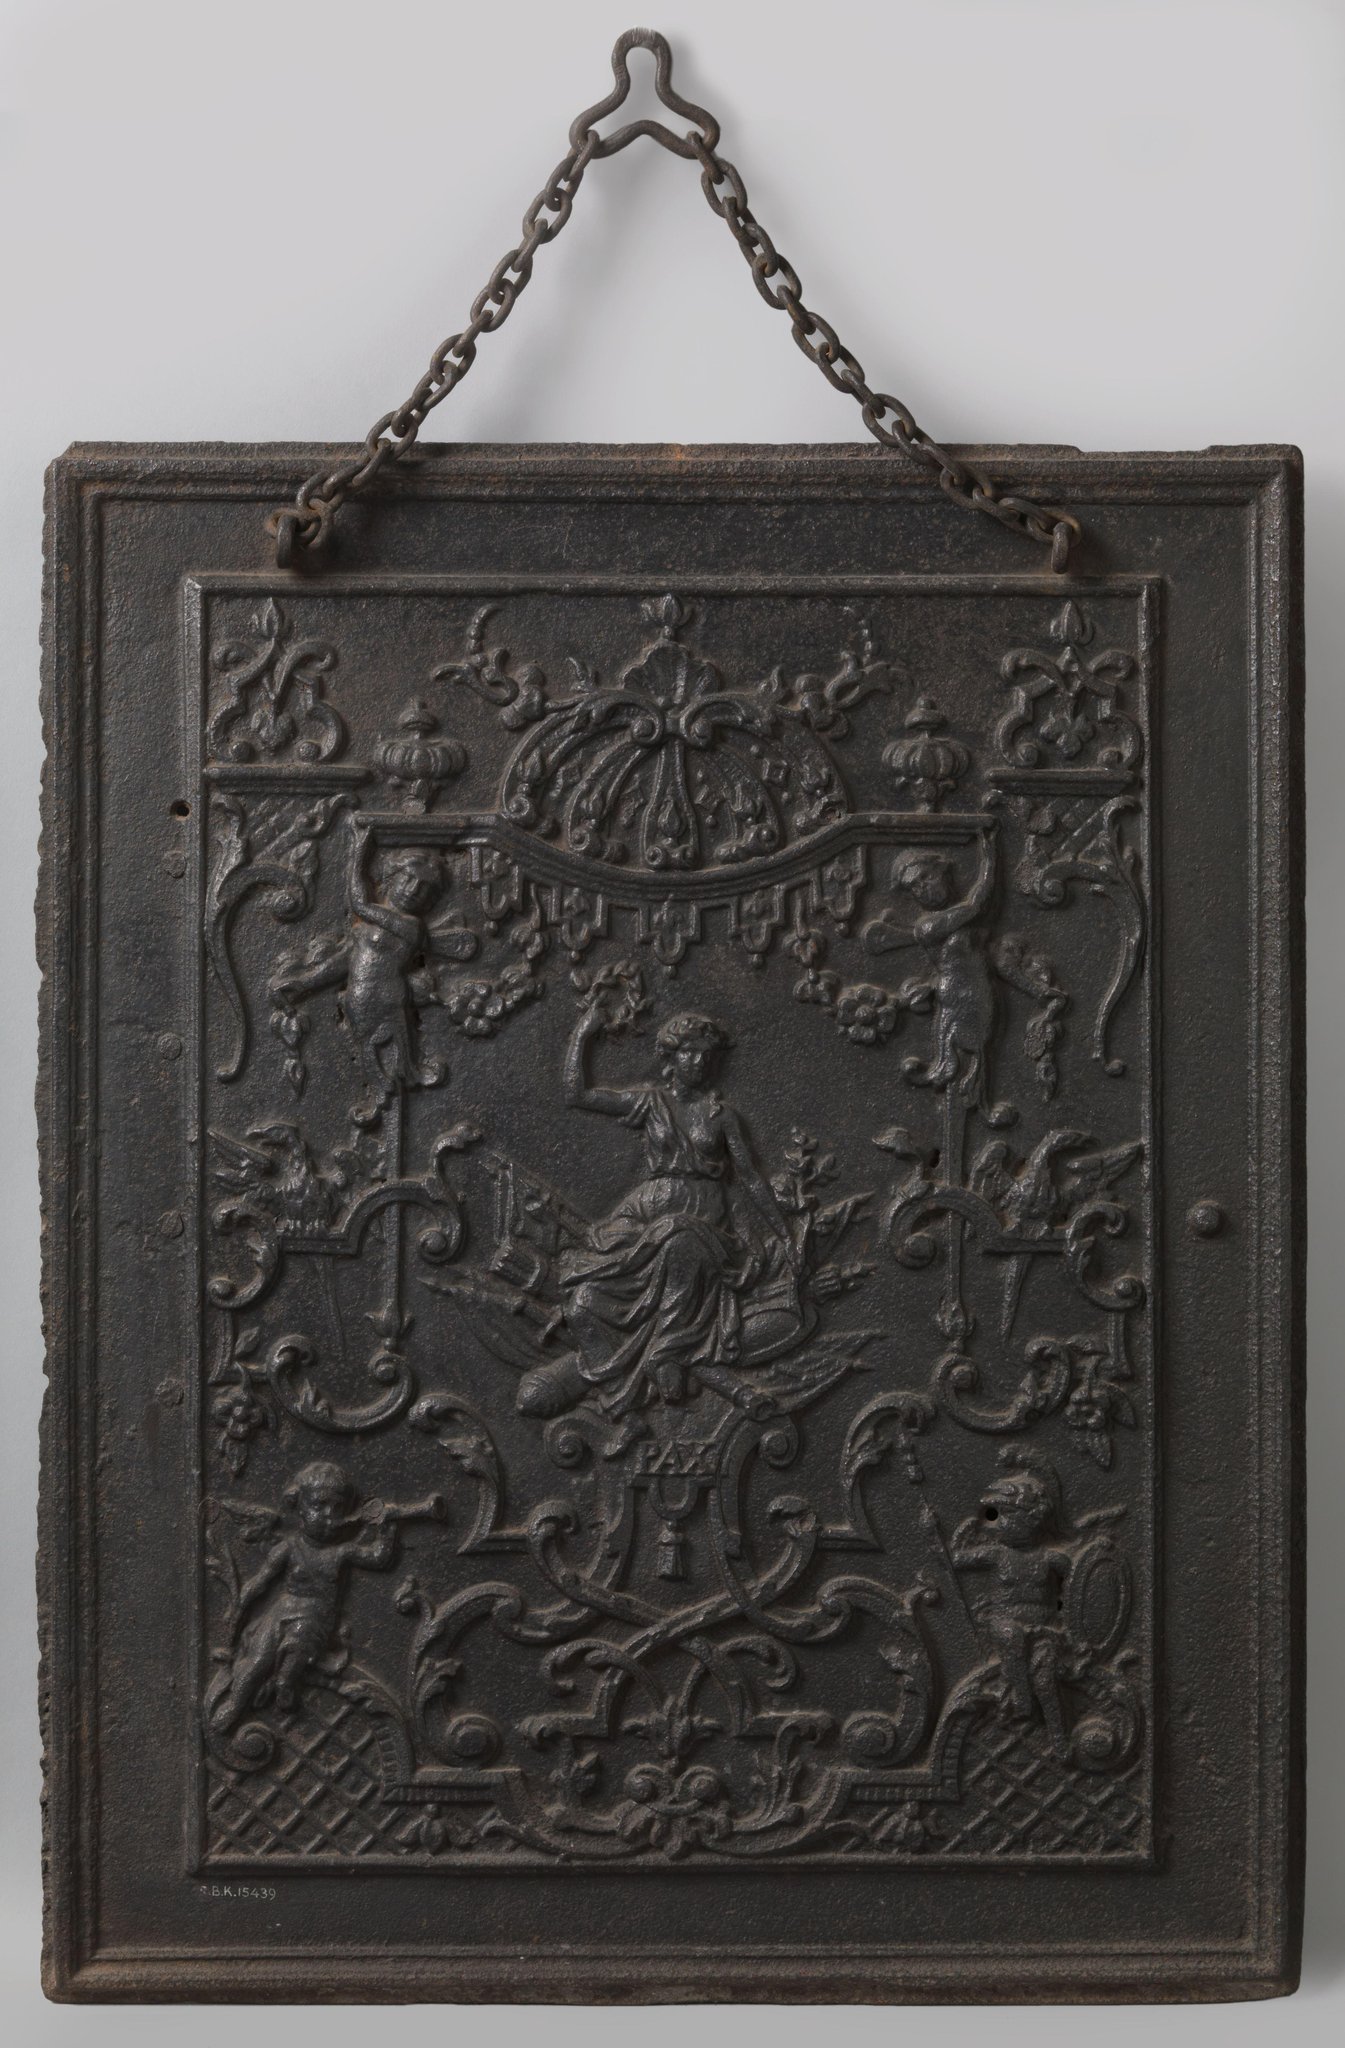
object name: fireback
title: Haardplaat met de Vrede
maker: Anonymous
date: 1675-1725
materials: iron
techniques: casting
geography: low countries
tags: peace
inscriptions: inscription: ‘PAX’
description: Haardplaat van gietijzer, rechthoekig model. Centraal staat de personificatie van Vrede met een lauwerkrans en een olijftak in haar handen. Zij is gezetenop een troon, waarbij een wapentrofee dient als zitvlak en direct daaronder het opschrift PAX. Vrede op de troon is geplaatst onder een baldakijn, die wordt opgehouden door twee kariatide-achtige figuren, waarvan het onderlichaam uitmondt in gebladerte. Aan weerzijden van Vrede zit een vogel, met daaronder twee putti. De linker blaast op een bazuin, de rechter draagt een lans en schild. Het geheel wordt omringd door een geprofileerde lijst, die aan de linkerzijde is hersteld. Bovenaan zijn twee ringen geklonken, waaraan een ketting is bevestigd, zodat de plaat kan ophangen.